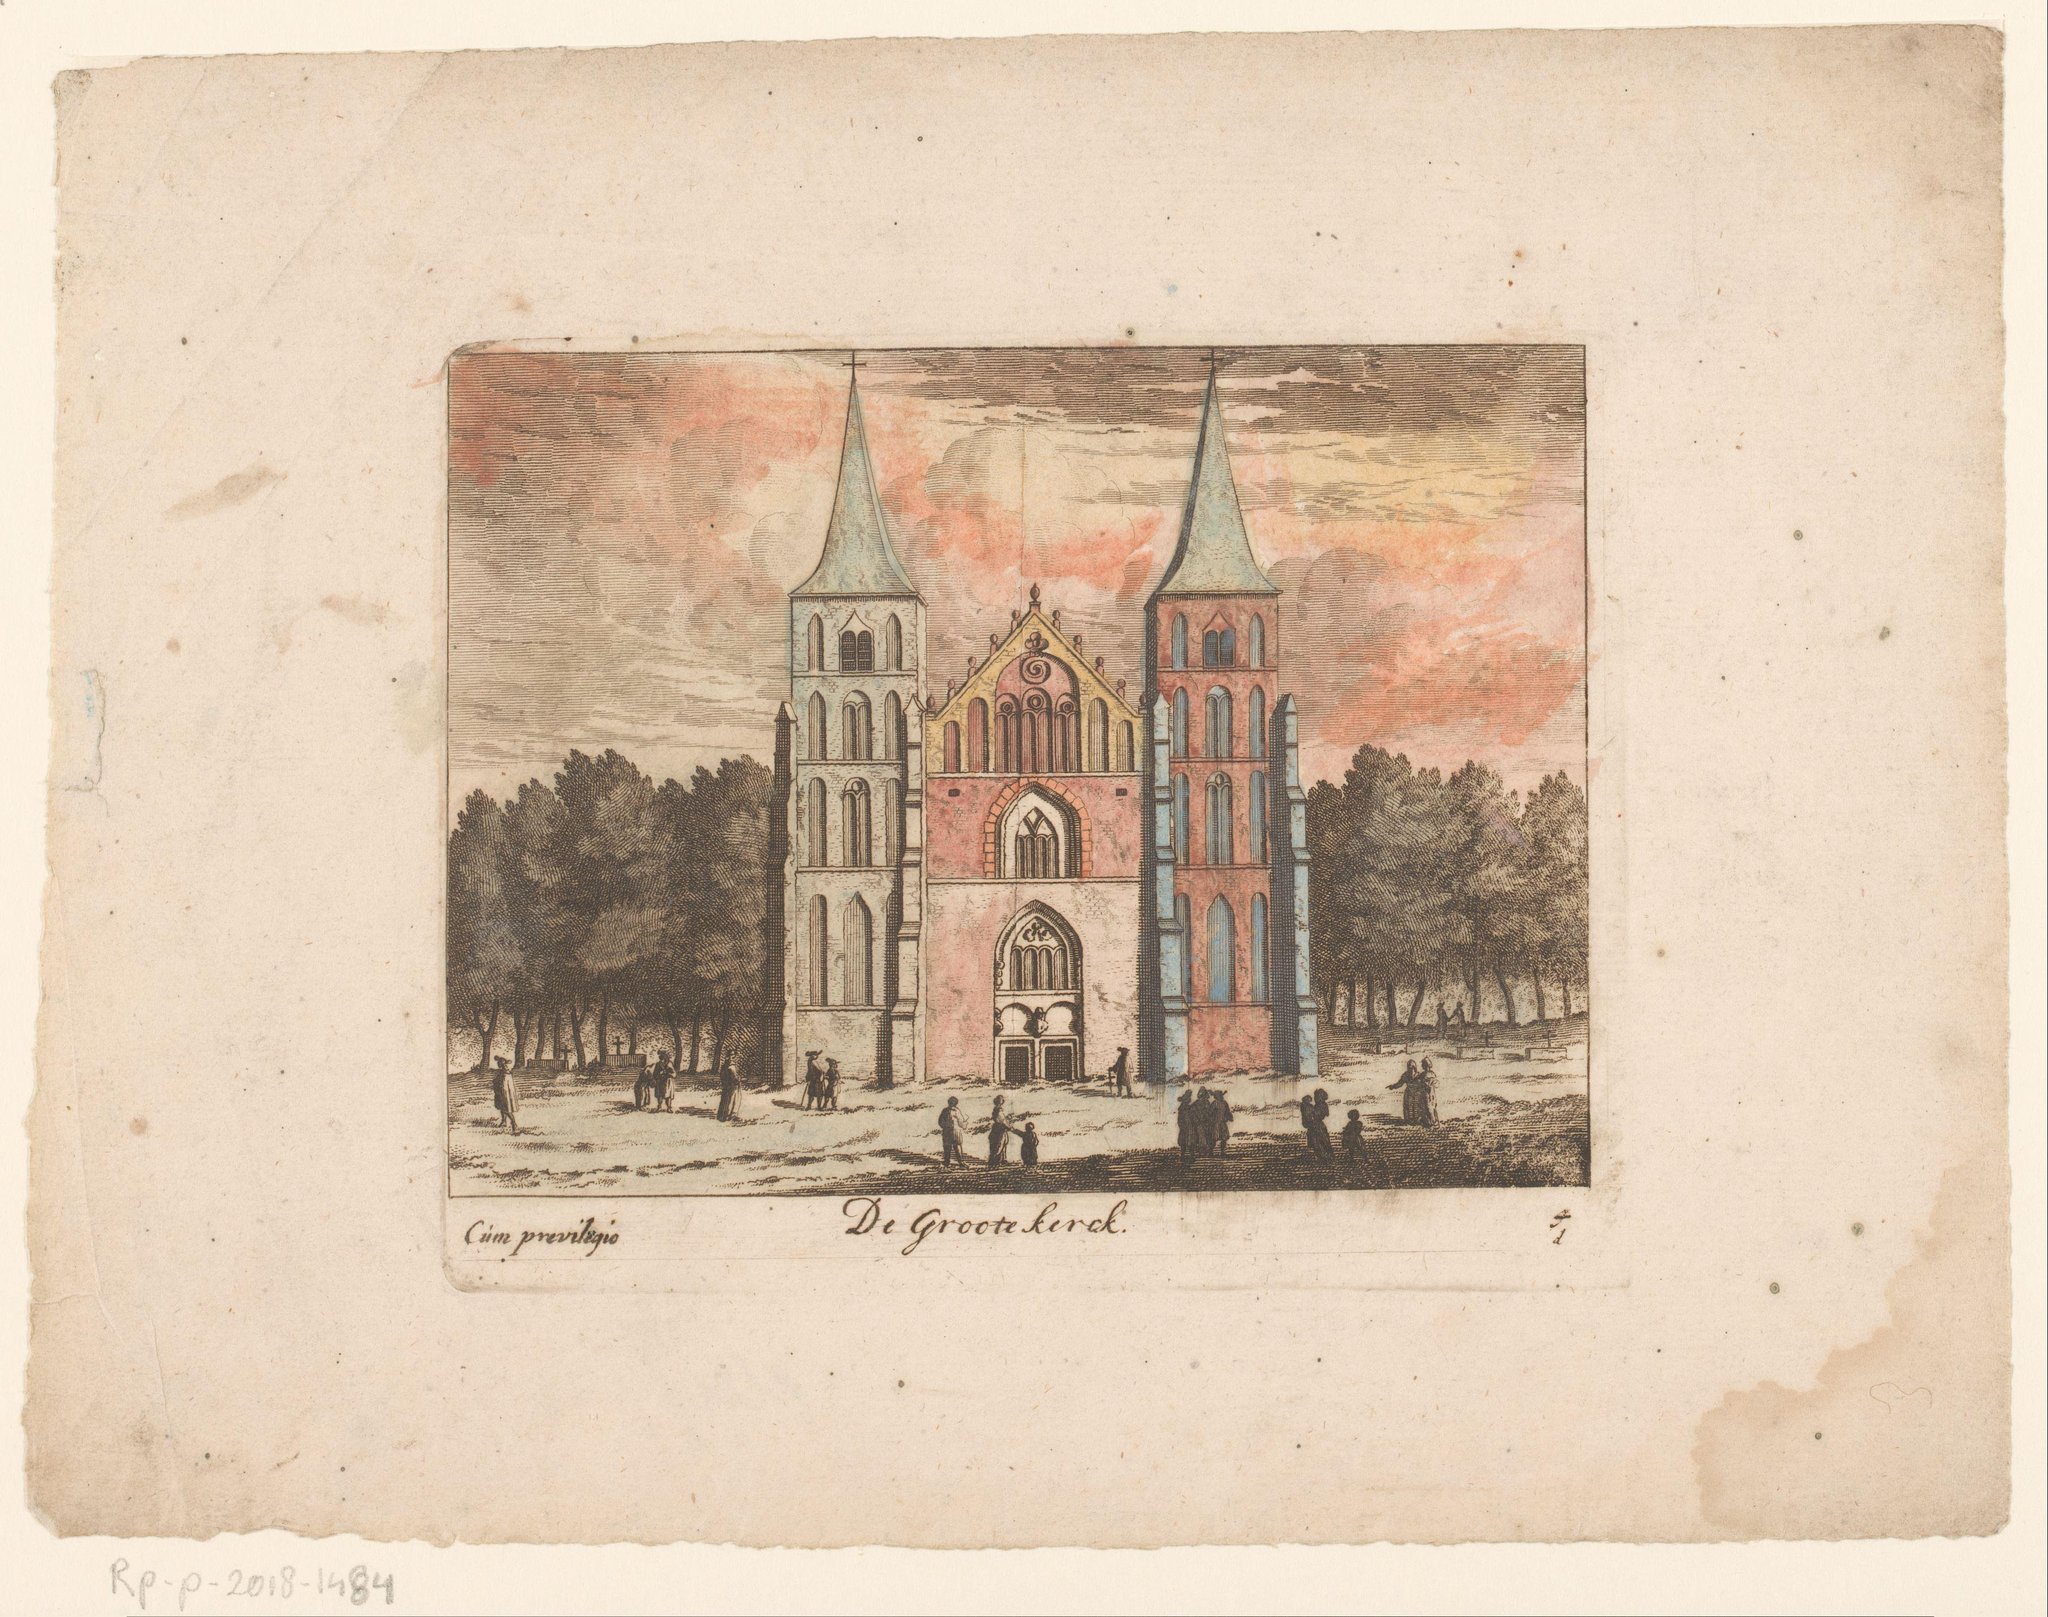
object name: print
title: De Groote kerck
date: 1695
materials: paper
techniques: engraving, etching, hand coloring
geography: amsterdam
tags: church (exterior), cleves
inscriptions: collector's mark: Lugt 2228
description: Prent ook gebruikt in: Veues et perspectives de la ville de Cleves, et de sa cour. Amsterdam: Gerard Valck, 1695.